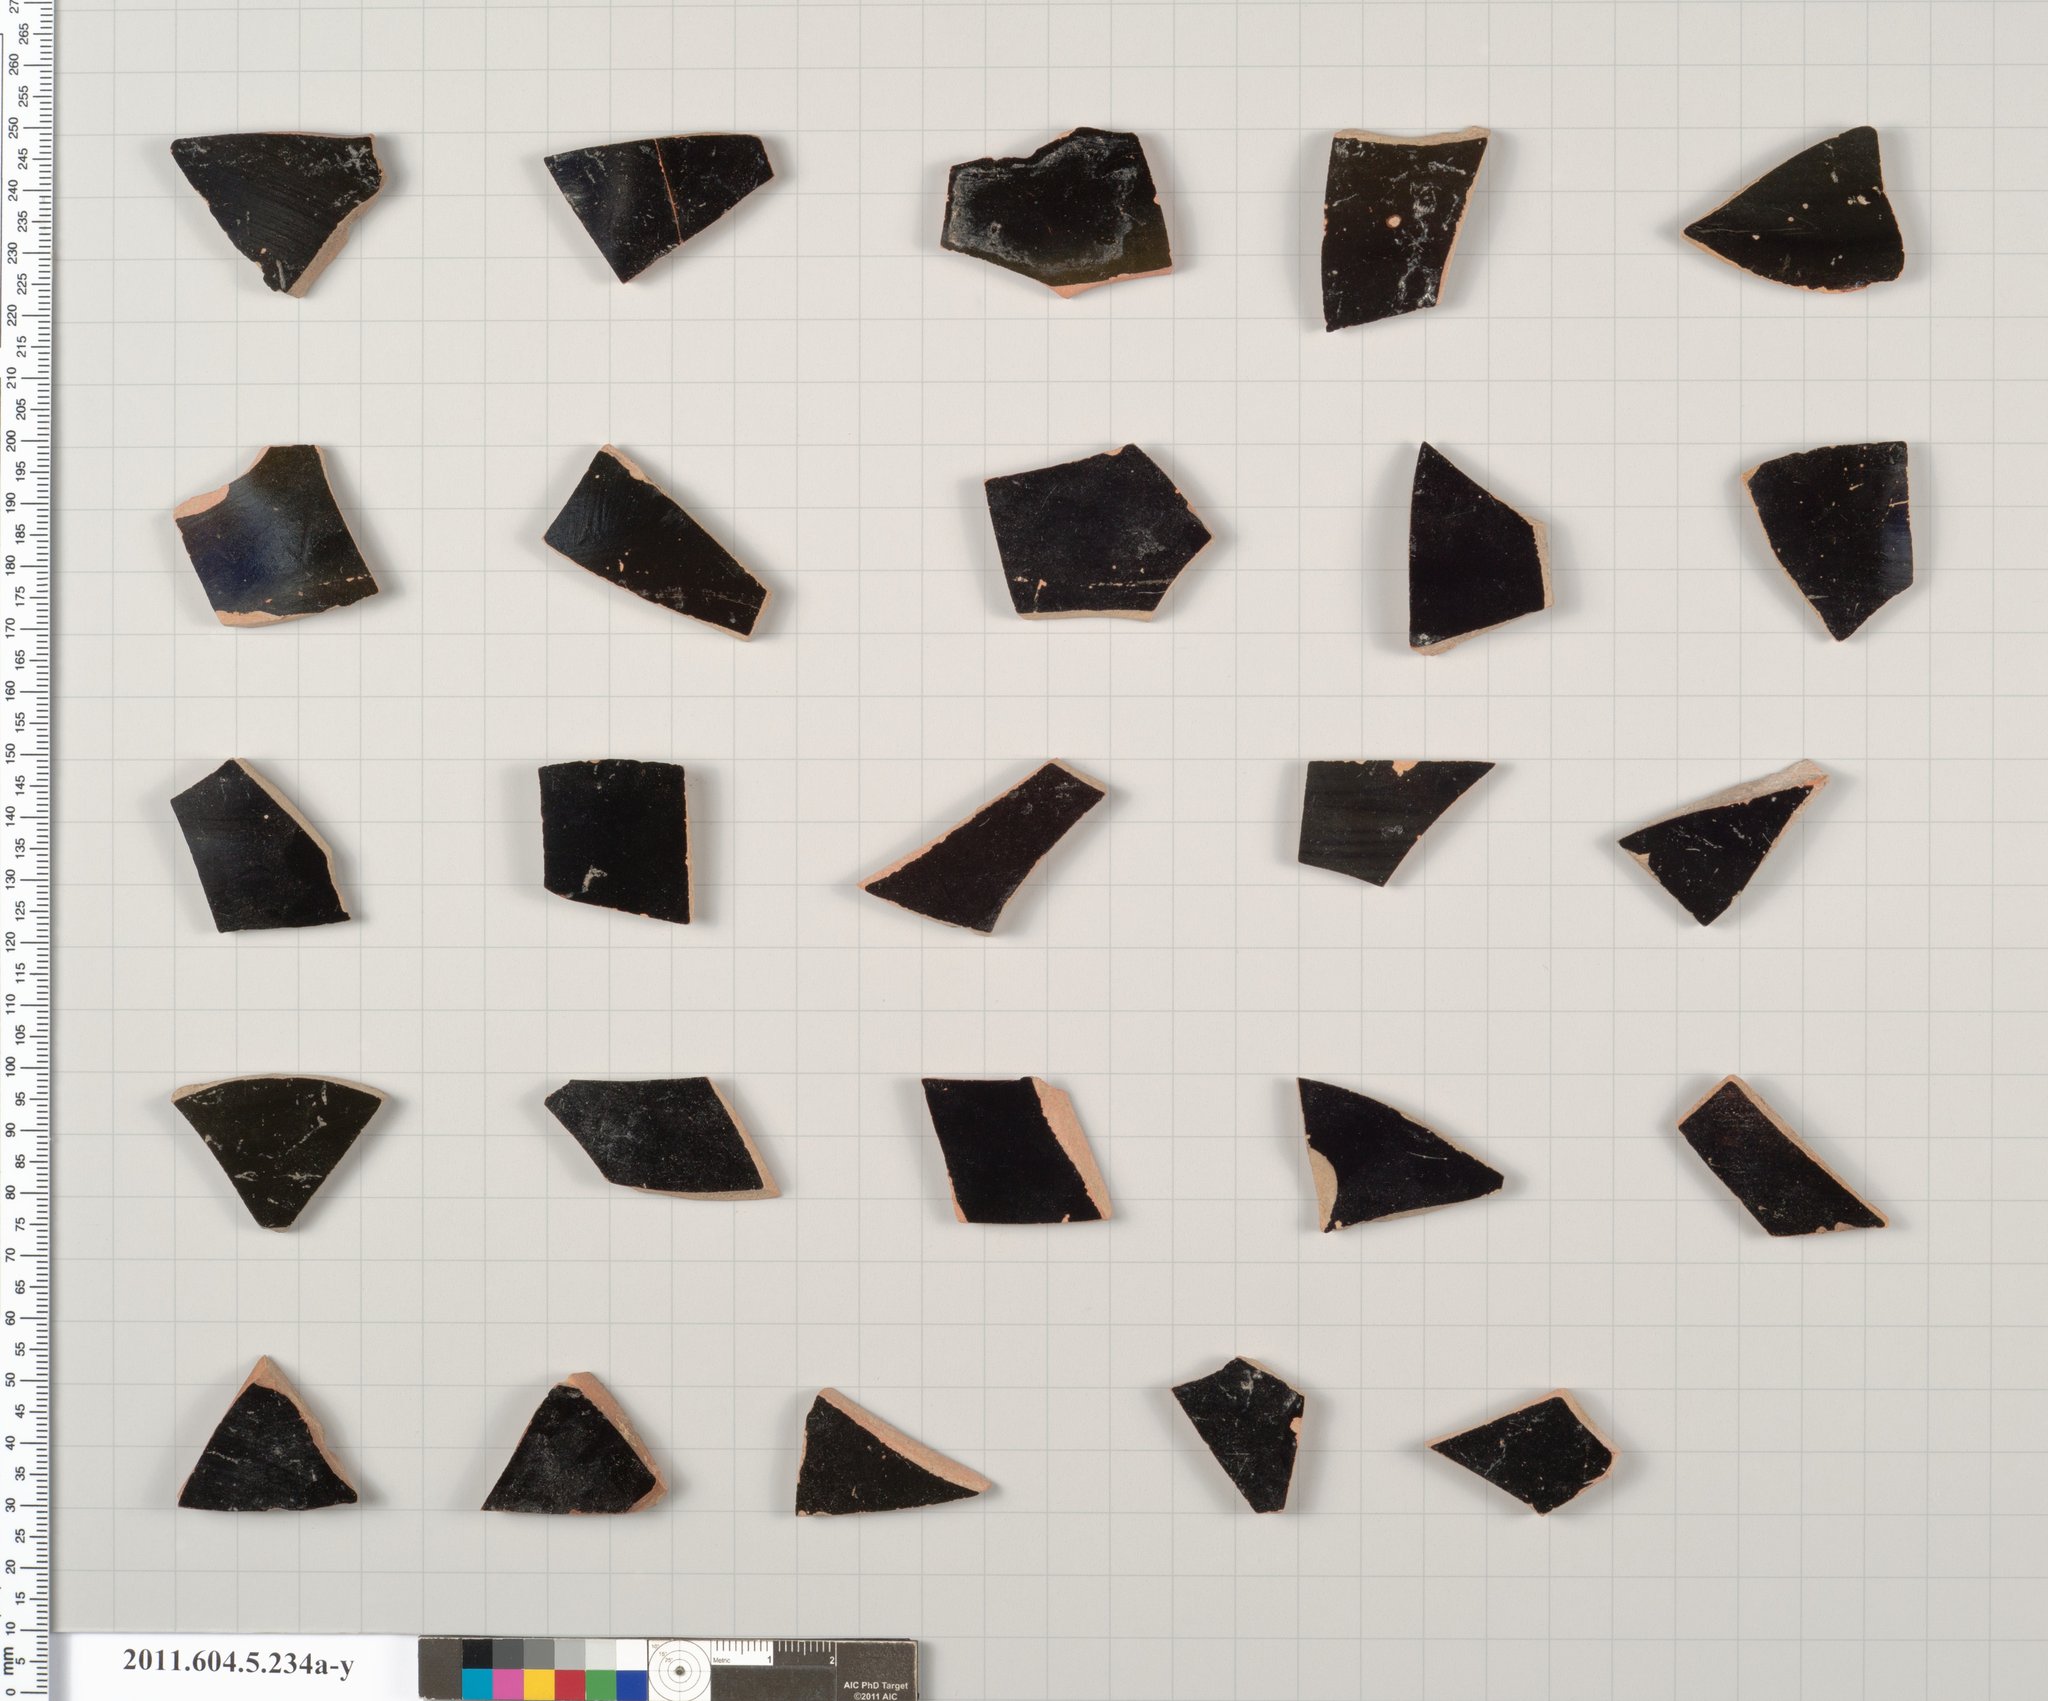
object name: kylix fragment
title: Terracotta fragments of kylikes (drinking cups)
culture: greek, attic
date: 600-401 BCE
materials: terracotta